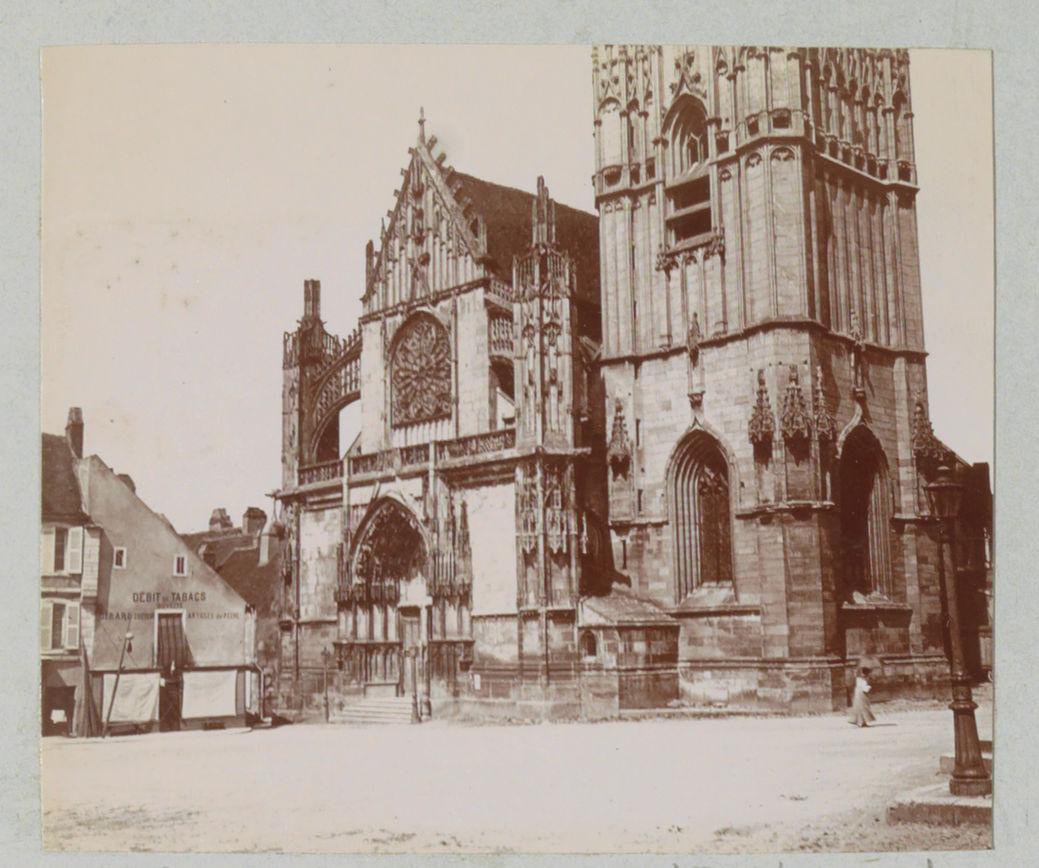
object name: photograph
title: Plein in Clamecy met de Église Saint-Martin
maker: delizy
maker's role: manufacturer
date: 1904-1907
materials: paper, photographic support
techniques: gelatin silver print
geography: clamecy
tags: church (exterior), square, place, circus, etc. (+ city(-scape) with figures, staffage)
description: Onderdeel van Fotoalbum van een Franse amateurfotograaf met opnames van uitstapjes in Frankrijk, Spanje, België, Luxemburg en Nederland, de eerste automobielen en autoraces.